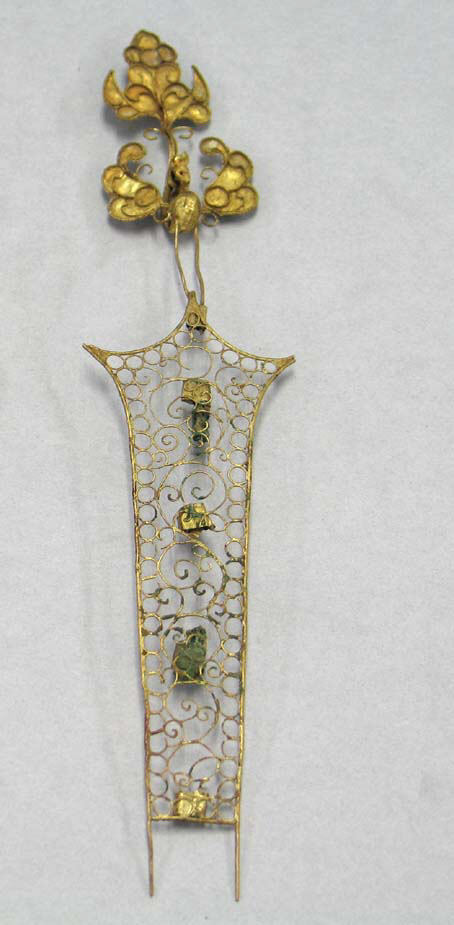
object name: ornament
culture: chinese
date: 618-907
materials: gold